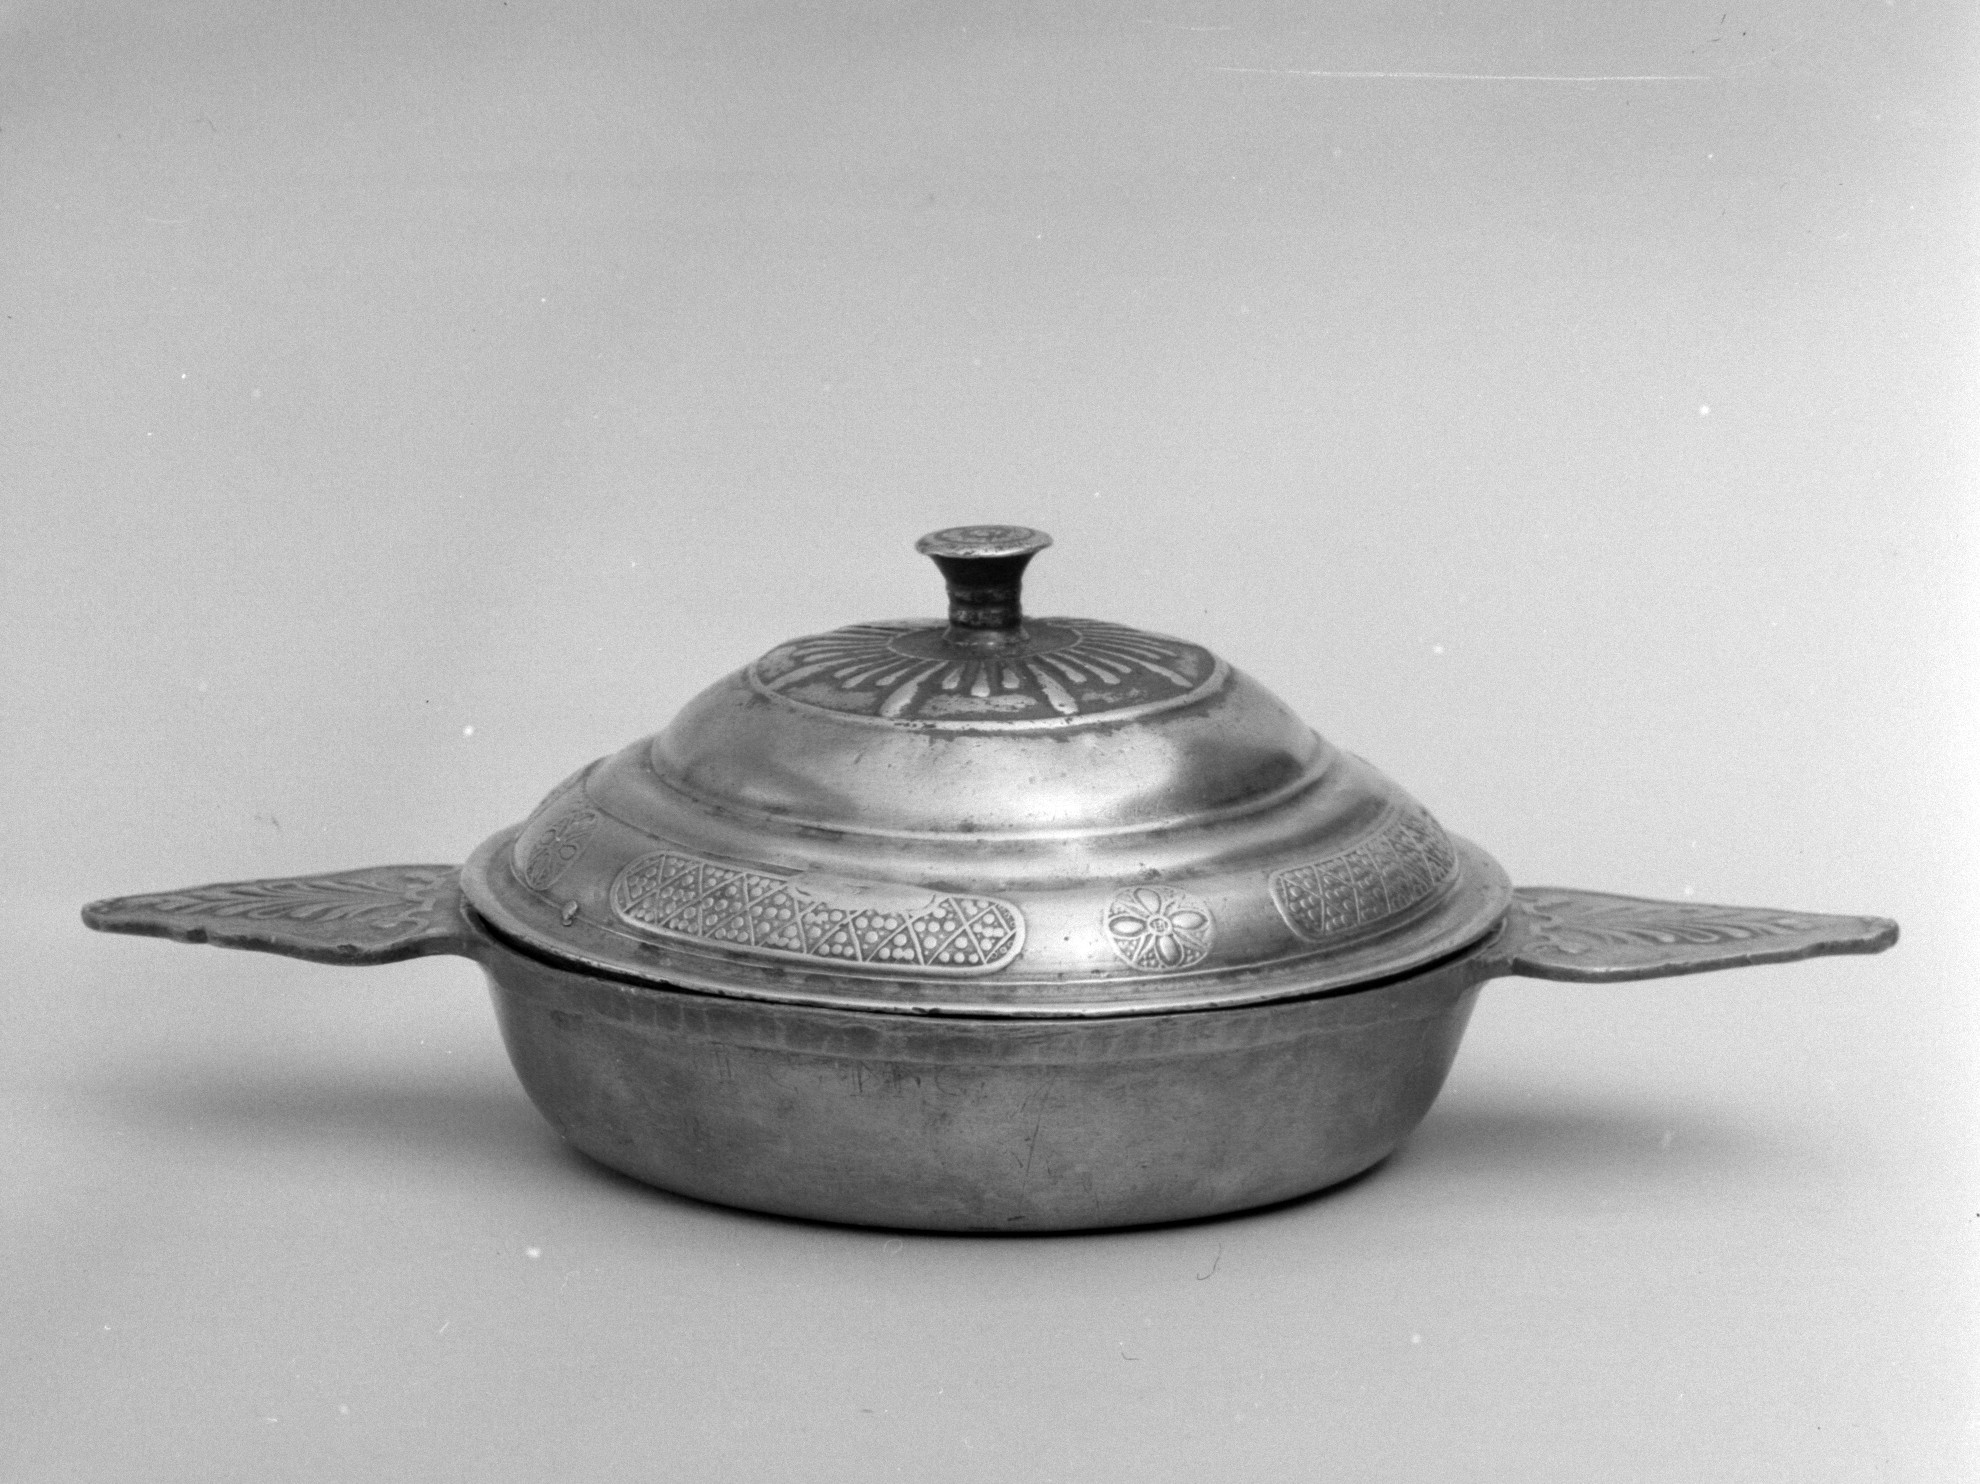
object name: dish with cover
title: Dish with cover (écuelle)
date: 1701-1800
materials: pewter